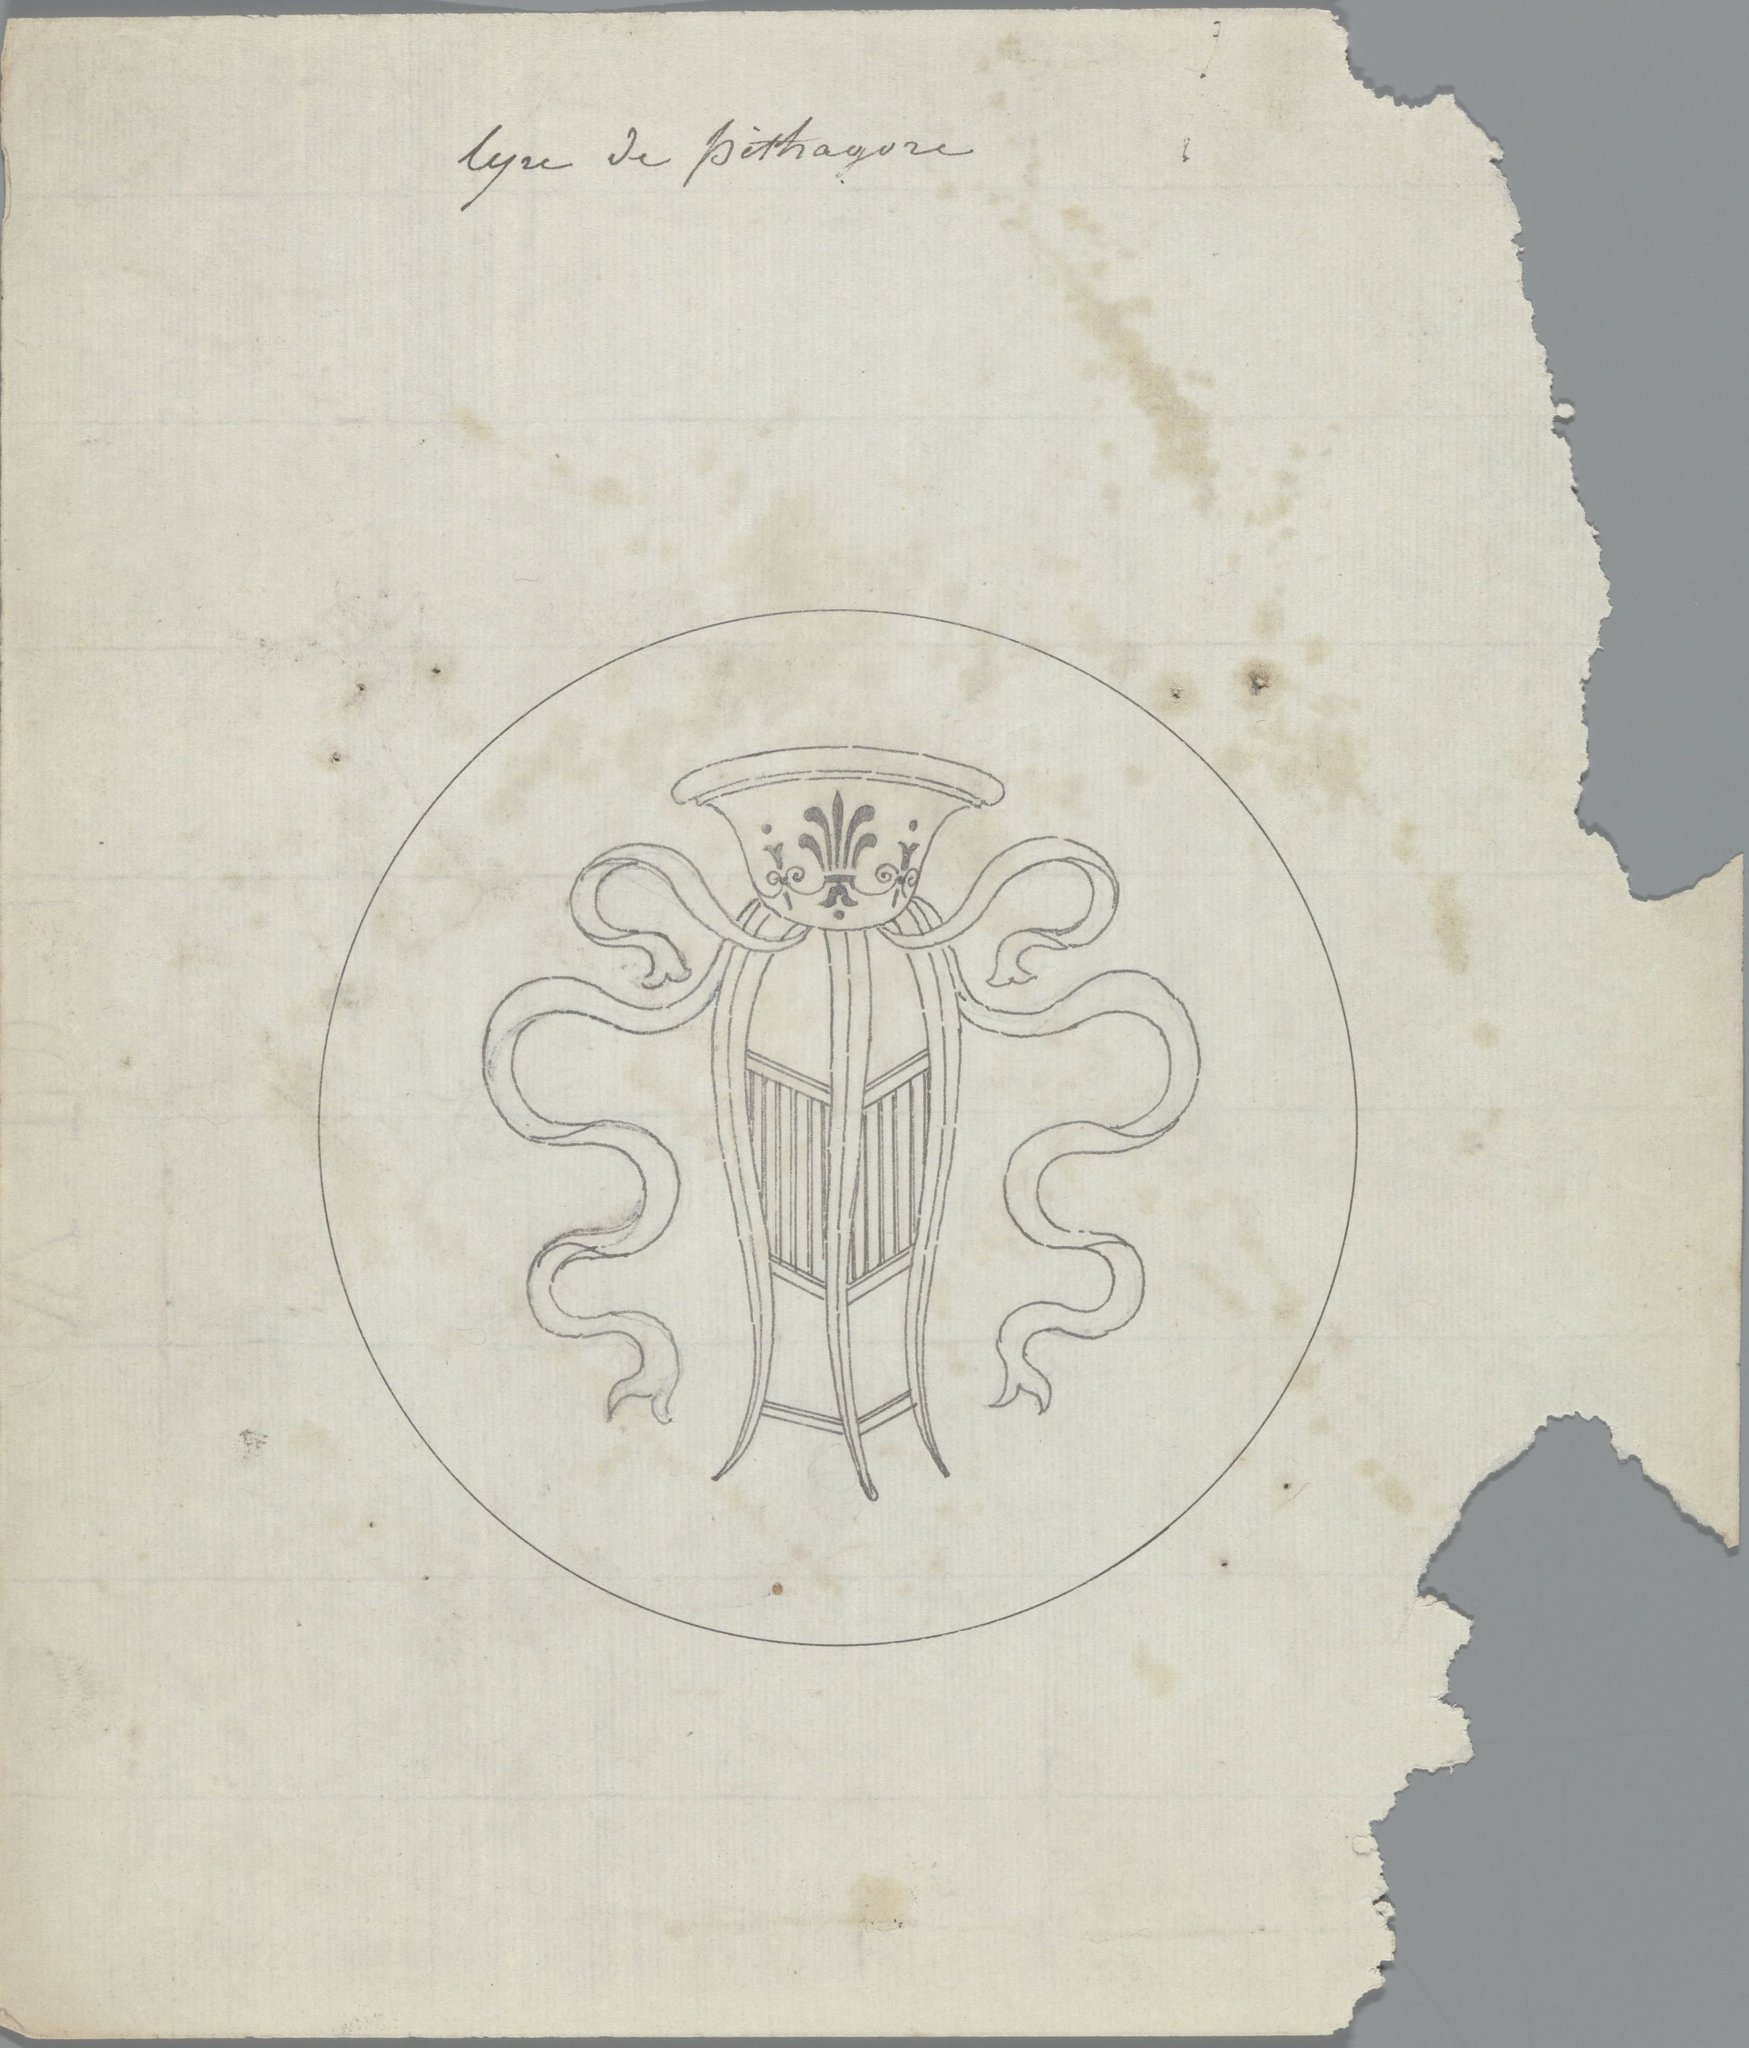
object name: design drawing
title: Lyre de pithagore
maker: pierre félix van doren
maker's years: 1797-1856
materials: graphite, ink, paper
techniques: pen in black ink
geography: brussels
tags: trophy, i.e.: decorative arrangement of symbolic or typical objects ~ ornament, lyre, cithara, psaltery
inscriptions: watermark: ‘VDL’, inscription: ‘lyre de pithagore’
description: Een van 103 ontwerpen voor marqueterie van aan linten opgehangen muziekinstrumenten in ronde medaillons, bestemd voor de set stoelen gemaakt door Van Doren voor de grote zaal van het Paleis van de Prins van Oranje in Brussel in 1828.